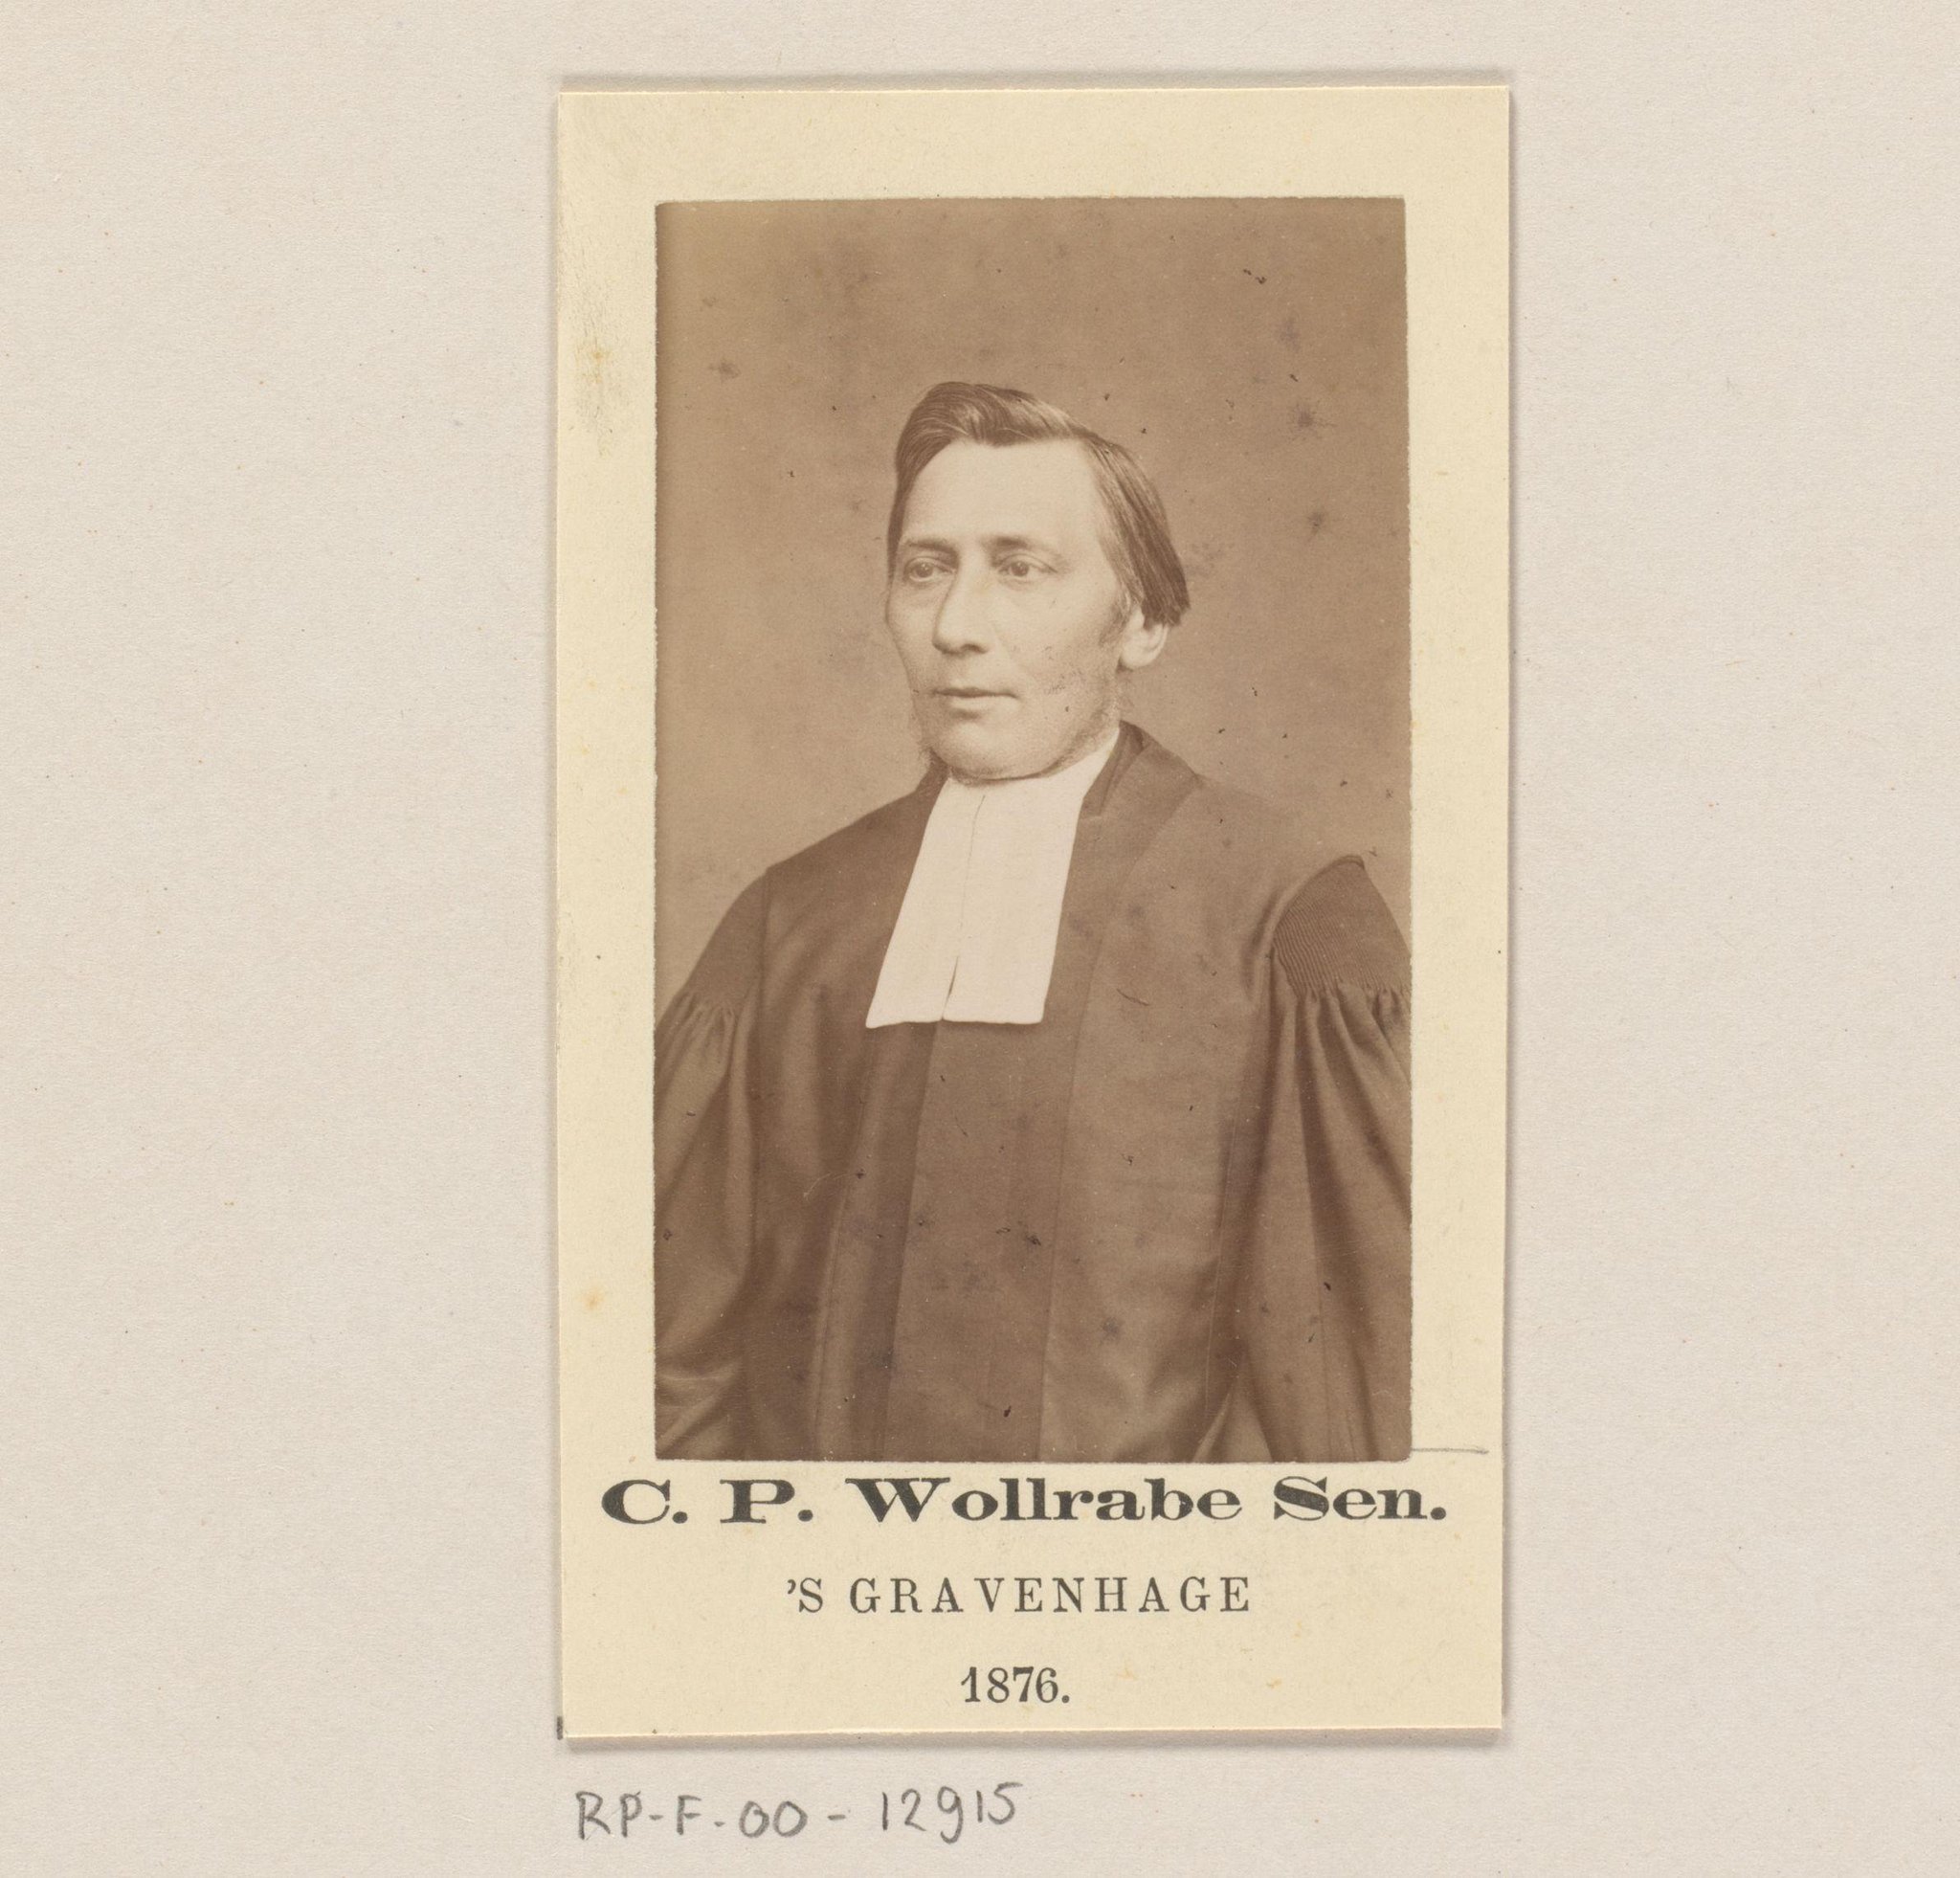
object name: photograph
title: Portret van Johannes Cornelis Zaalberg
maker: carl philip wollrabe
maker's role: fotograaf, musicus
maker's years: 1812-1887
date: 1876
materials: cardboard, paper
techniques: albumen print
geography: the hague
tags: historical persons